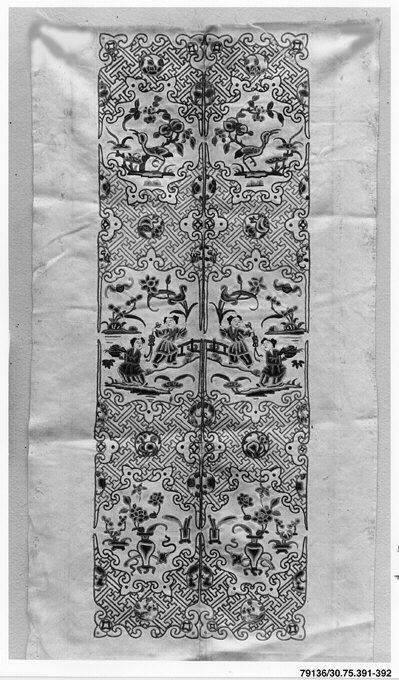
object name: sleeve band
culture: chinese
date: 1801-1900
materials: metal thread, silk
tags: human figures,flowers,plants